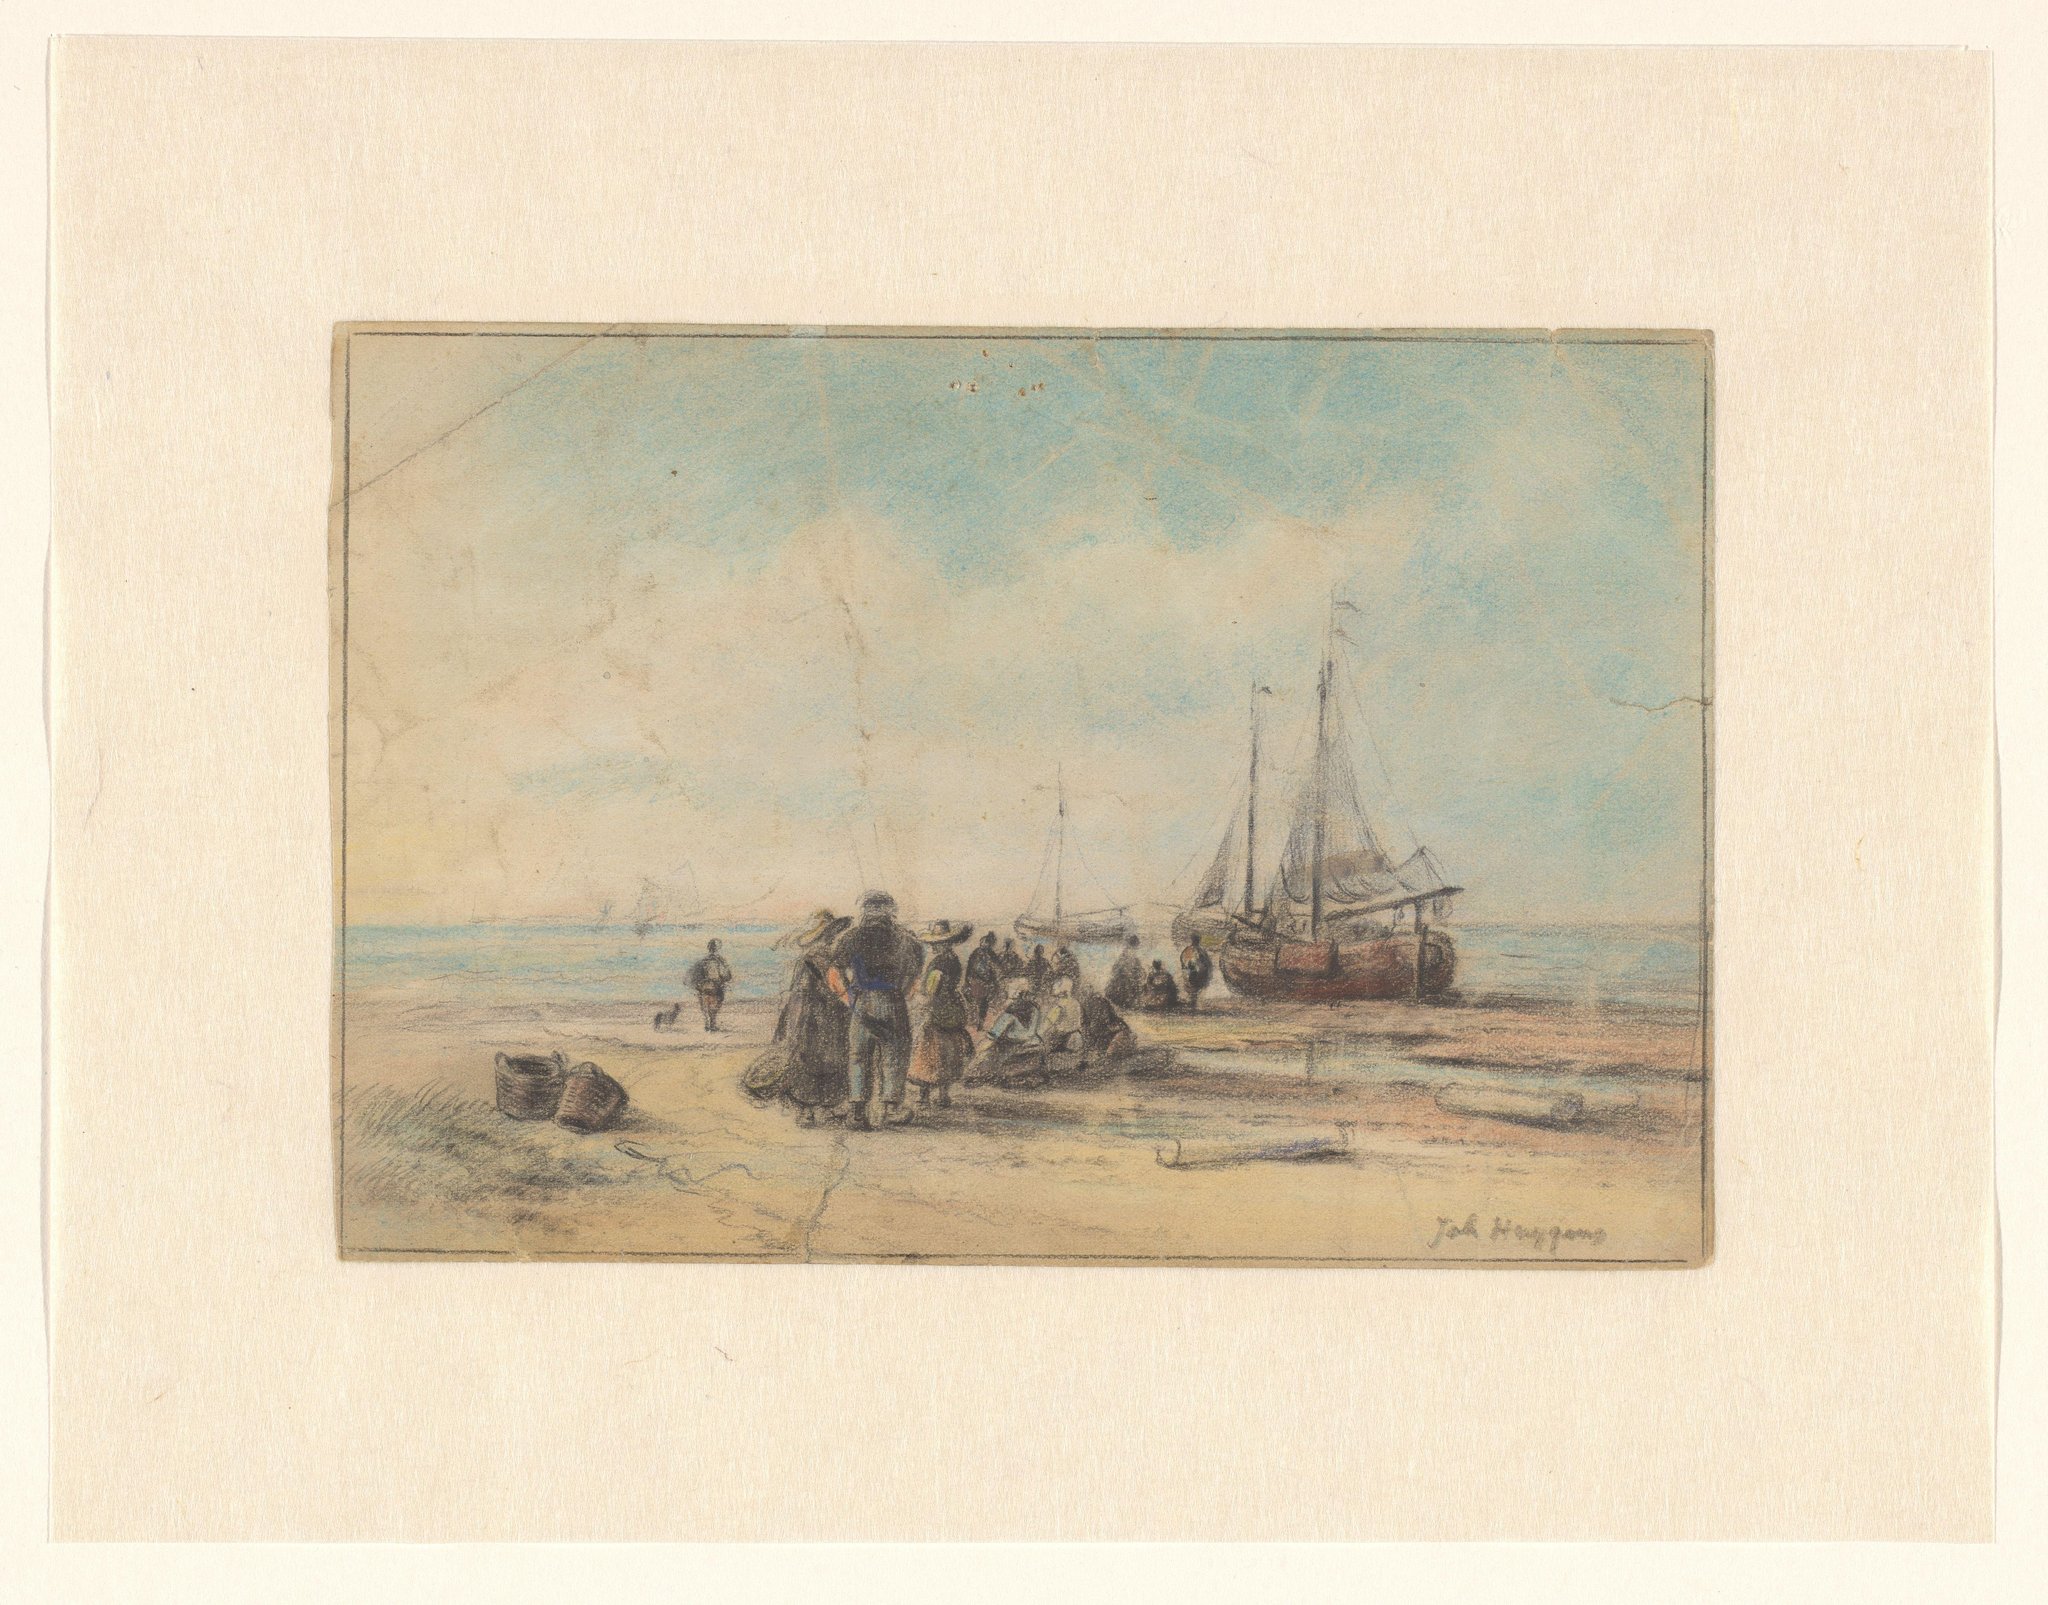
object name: drawing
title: Vissers bij aangemeerde schepen op het strand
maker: johannes huygens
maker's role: draughtsman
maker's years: 1833-1911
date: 1843-1911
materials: chalk, paper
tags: sailing-ship, sailing-boat, beach (+ landscape with figures, staffage)